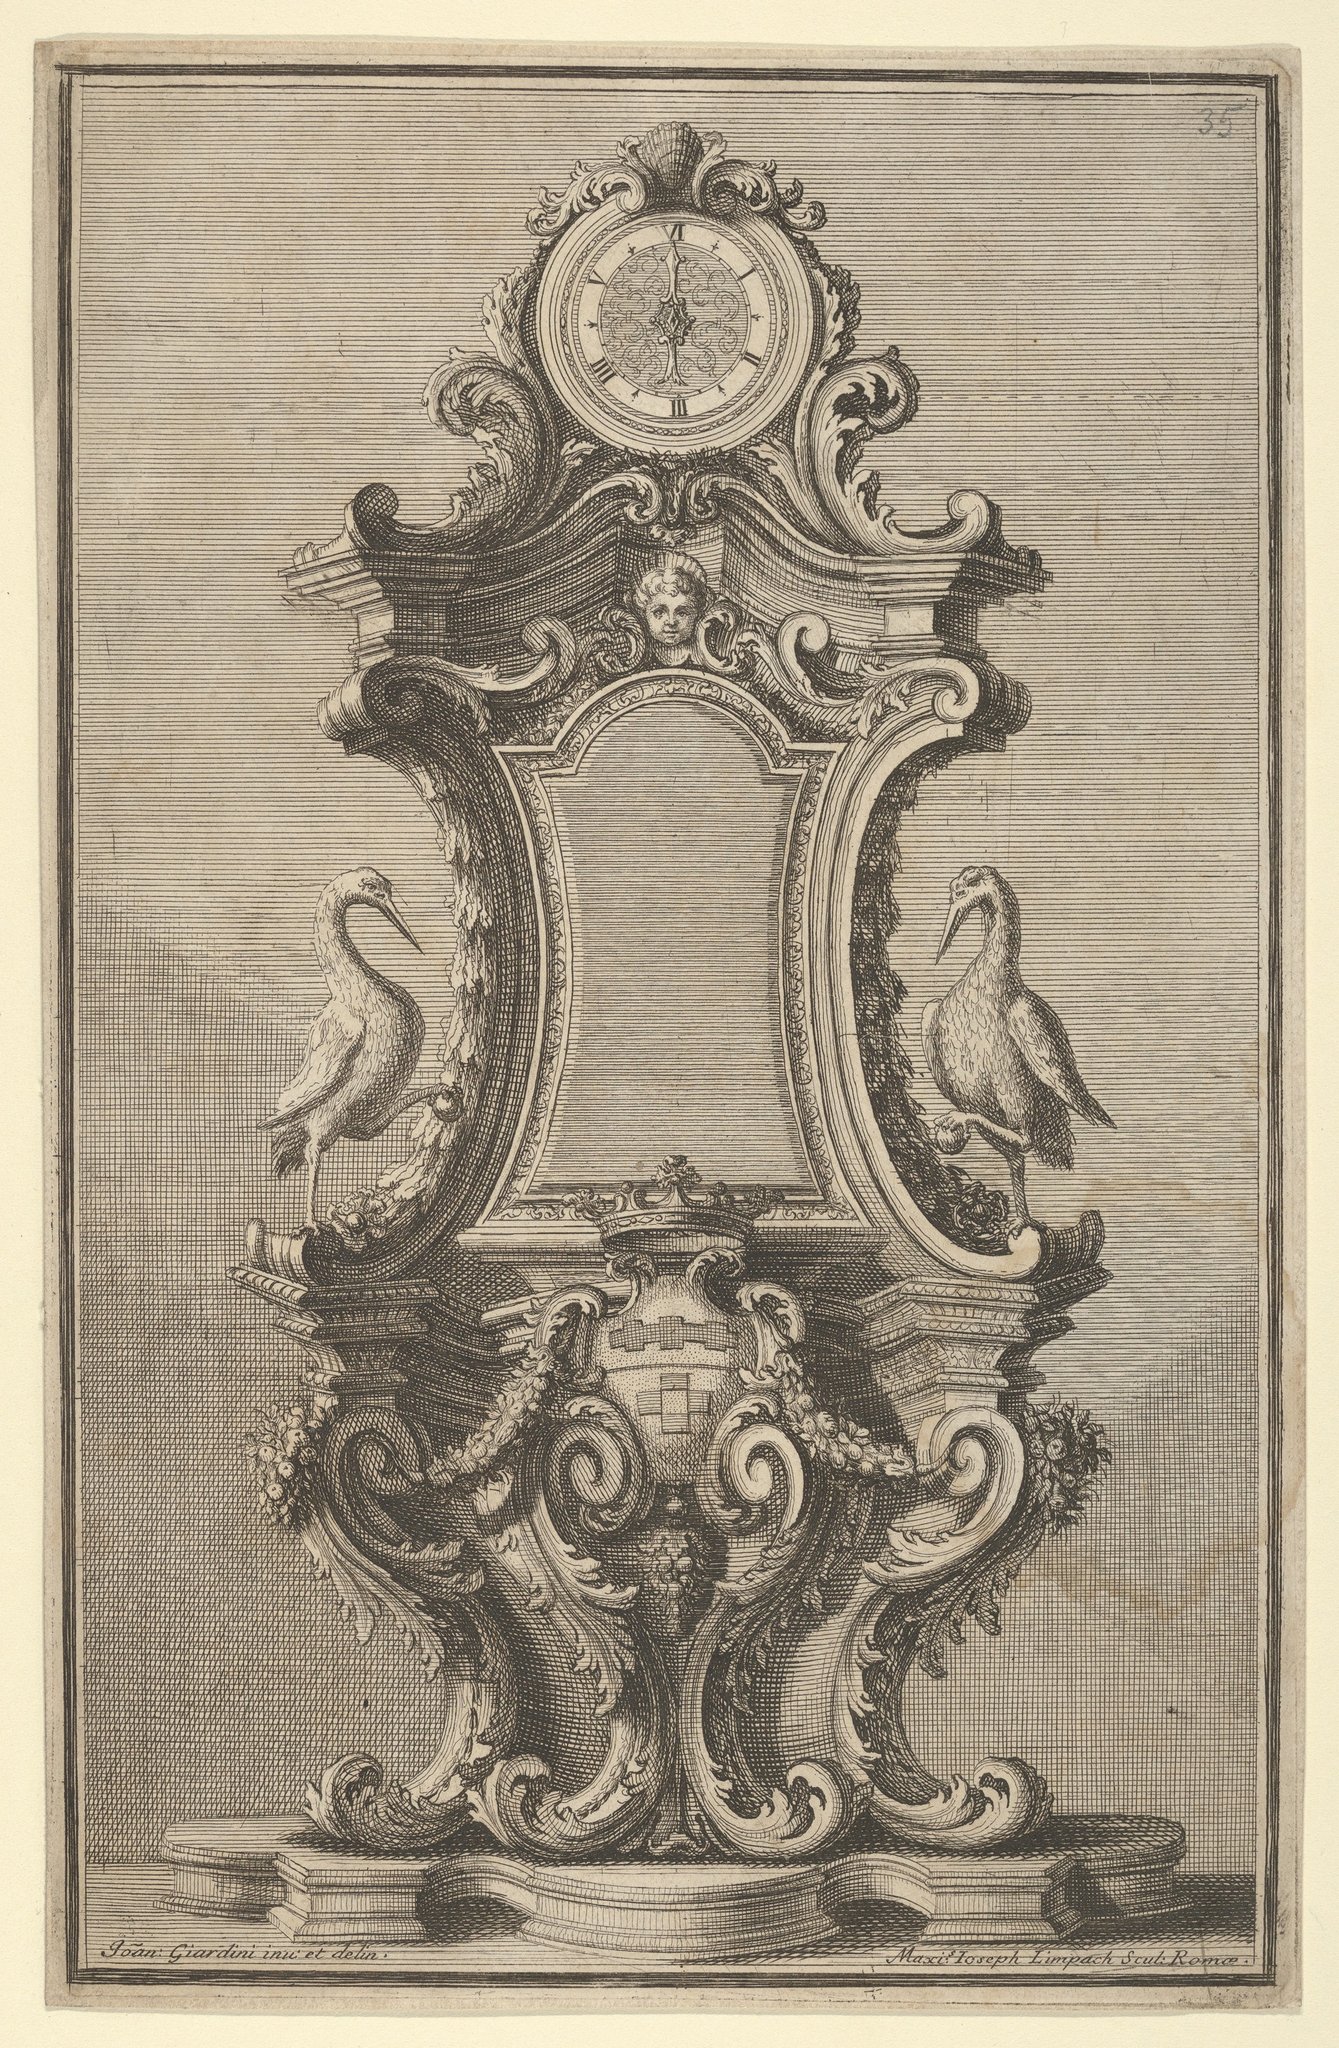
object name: print ornament architecture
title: Design for a Clock, from 'Disegni Diversi'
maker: giovanni giardini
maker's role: artist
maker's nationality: italian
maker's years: 1646-1722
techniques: engraving, etching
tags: birds,coat of arms,clocks,mirrors